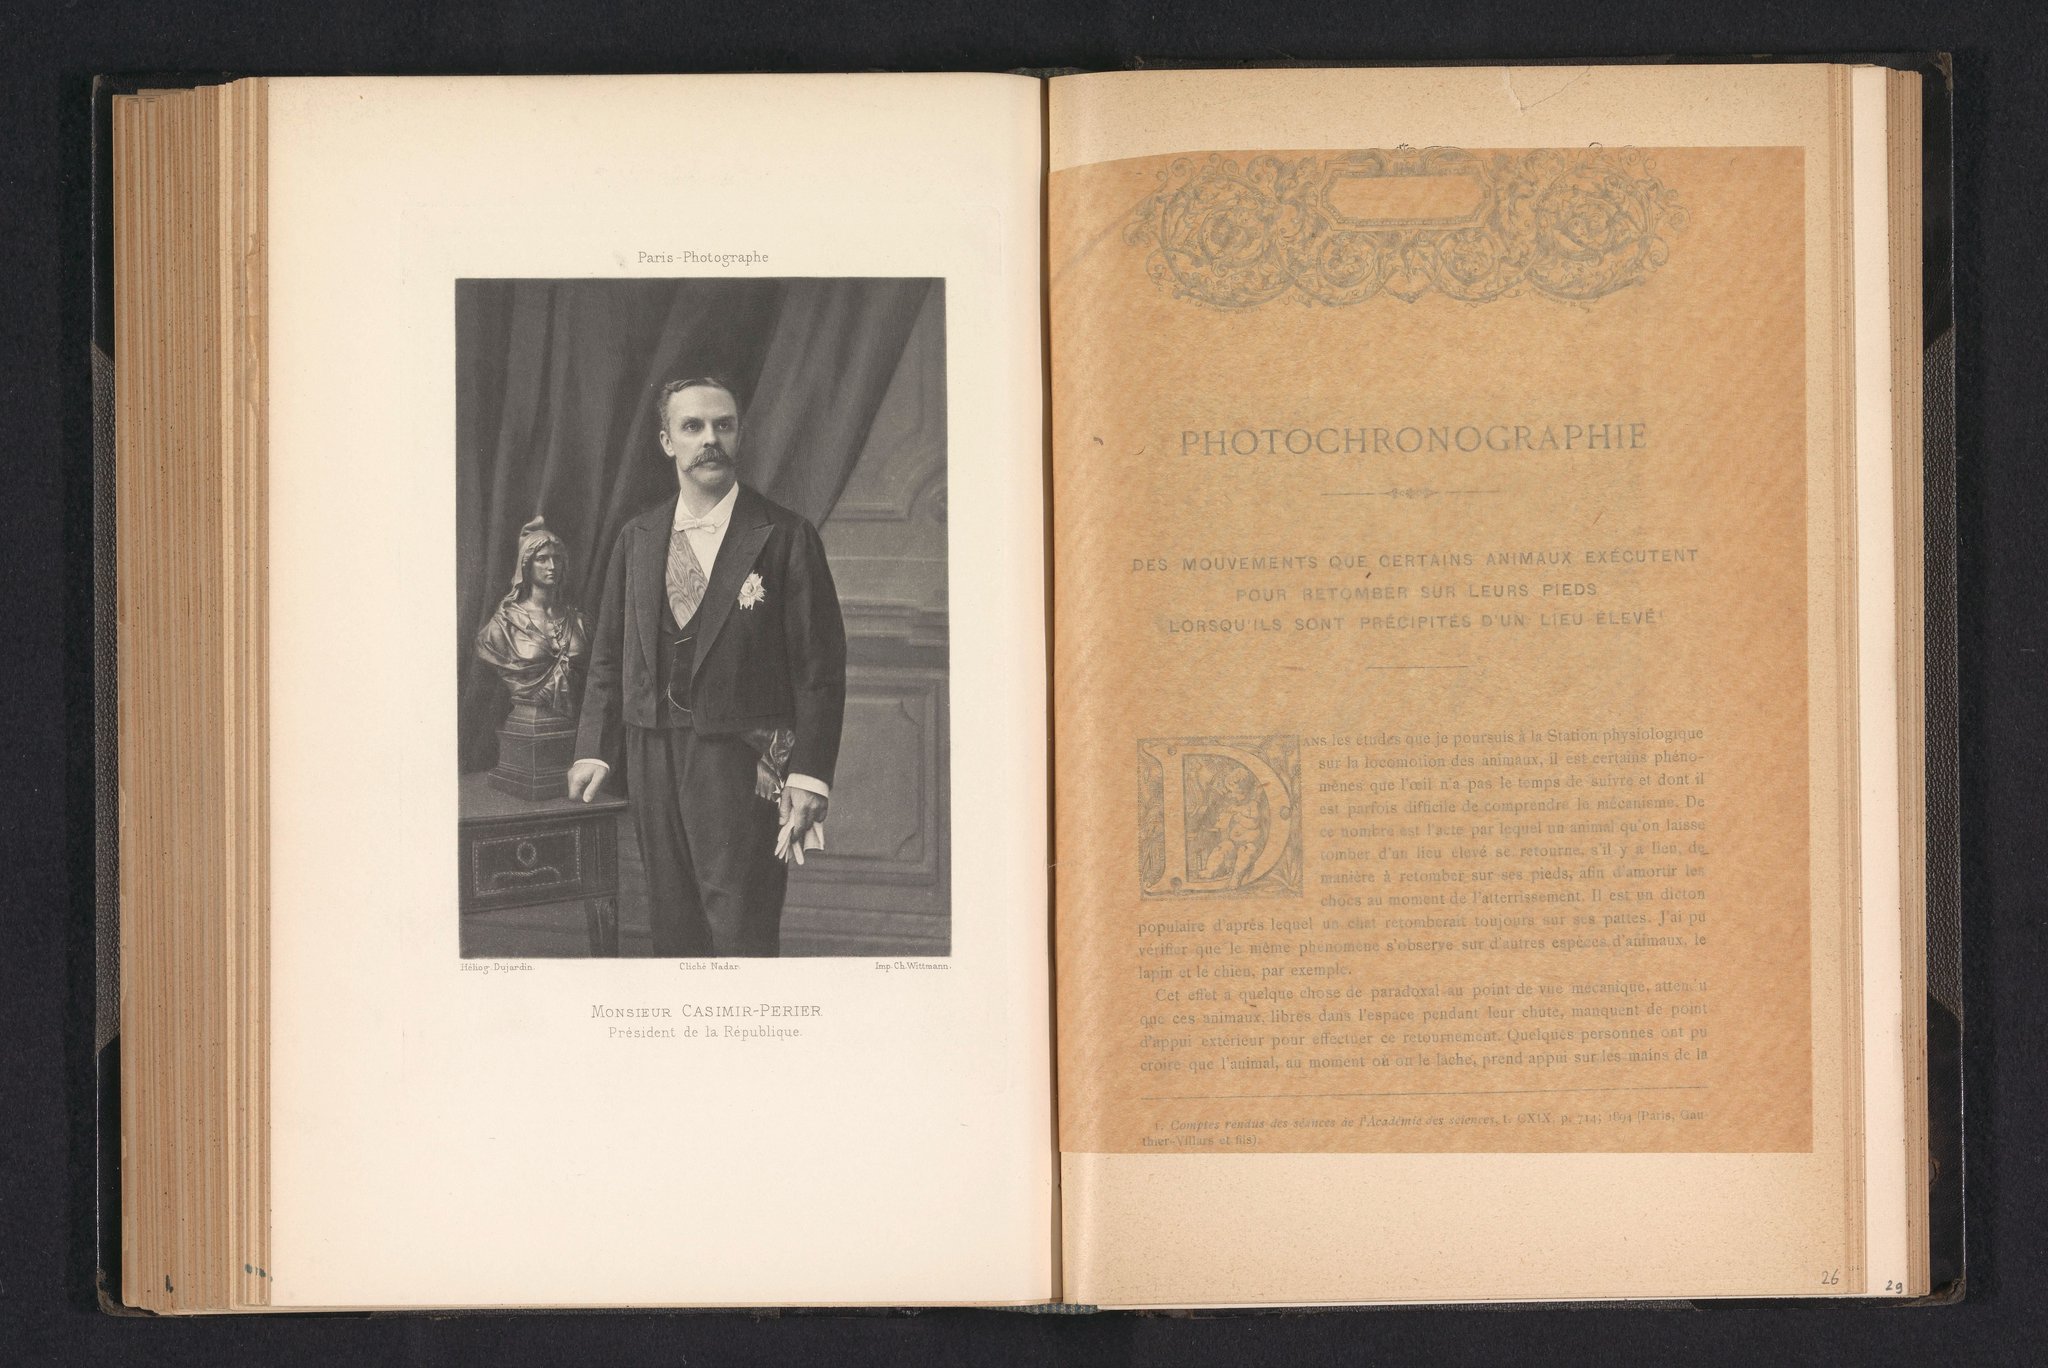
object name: photomechanical print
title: Portret van Jean Casimir-Perier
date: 1884-1894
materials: paper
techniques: photoaquatint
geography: france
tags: politician, e.g. party leader